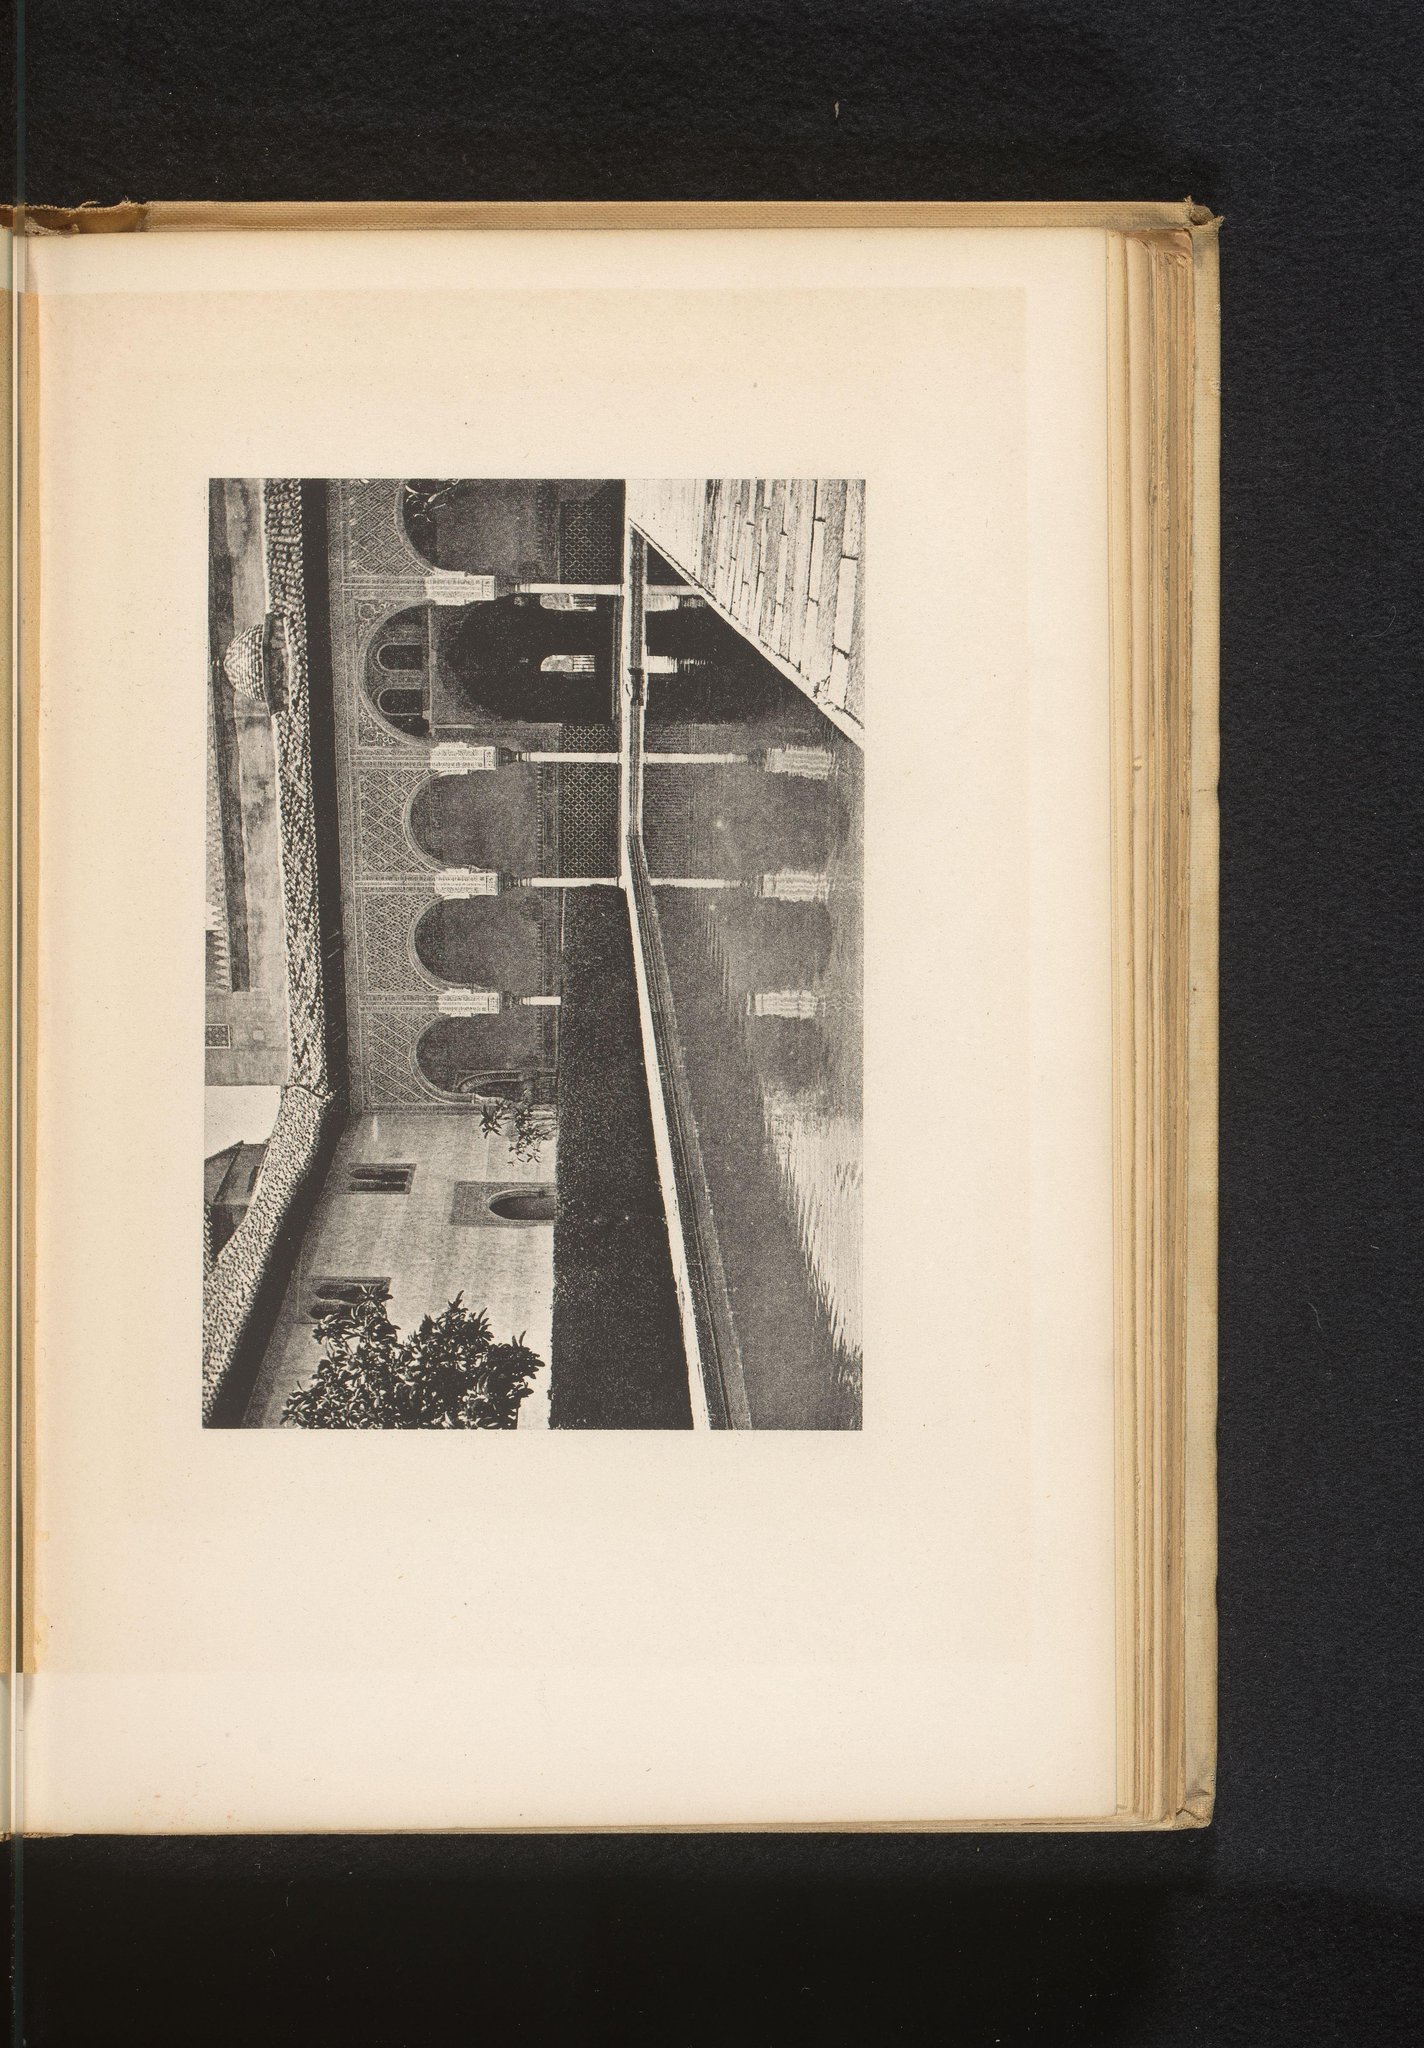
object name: photomechanical print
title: Patio de los Arrayanes in het Alhambra in Granada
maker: Anonymous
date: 1884-1894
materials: paper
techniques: photoaquatint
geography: alhambra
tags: pond, pool, courtyard